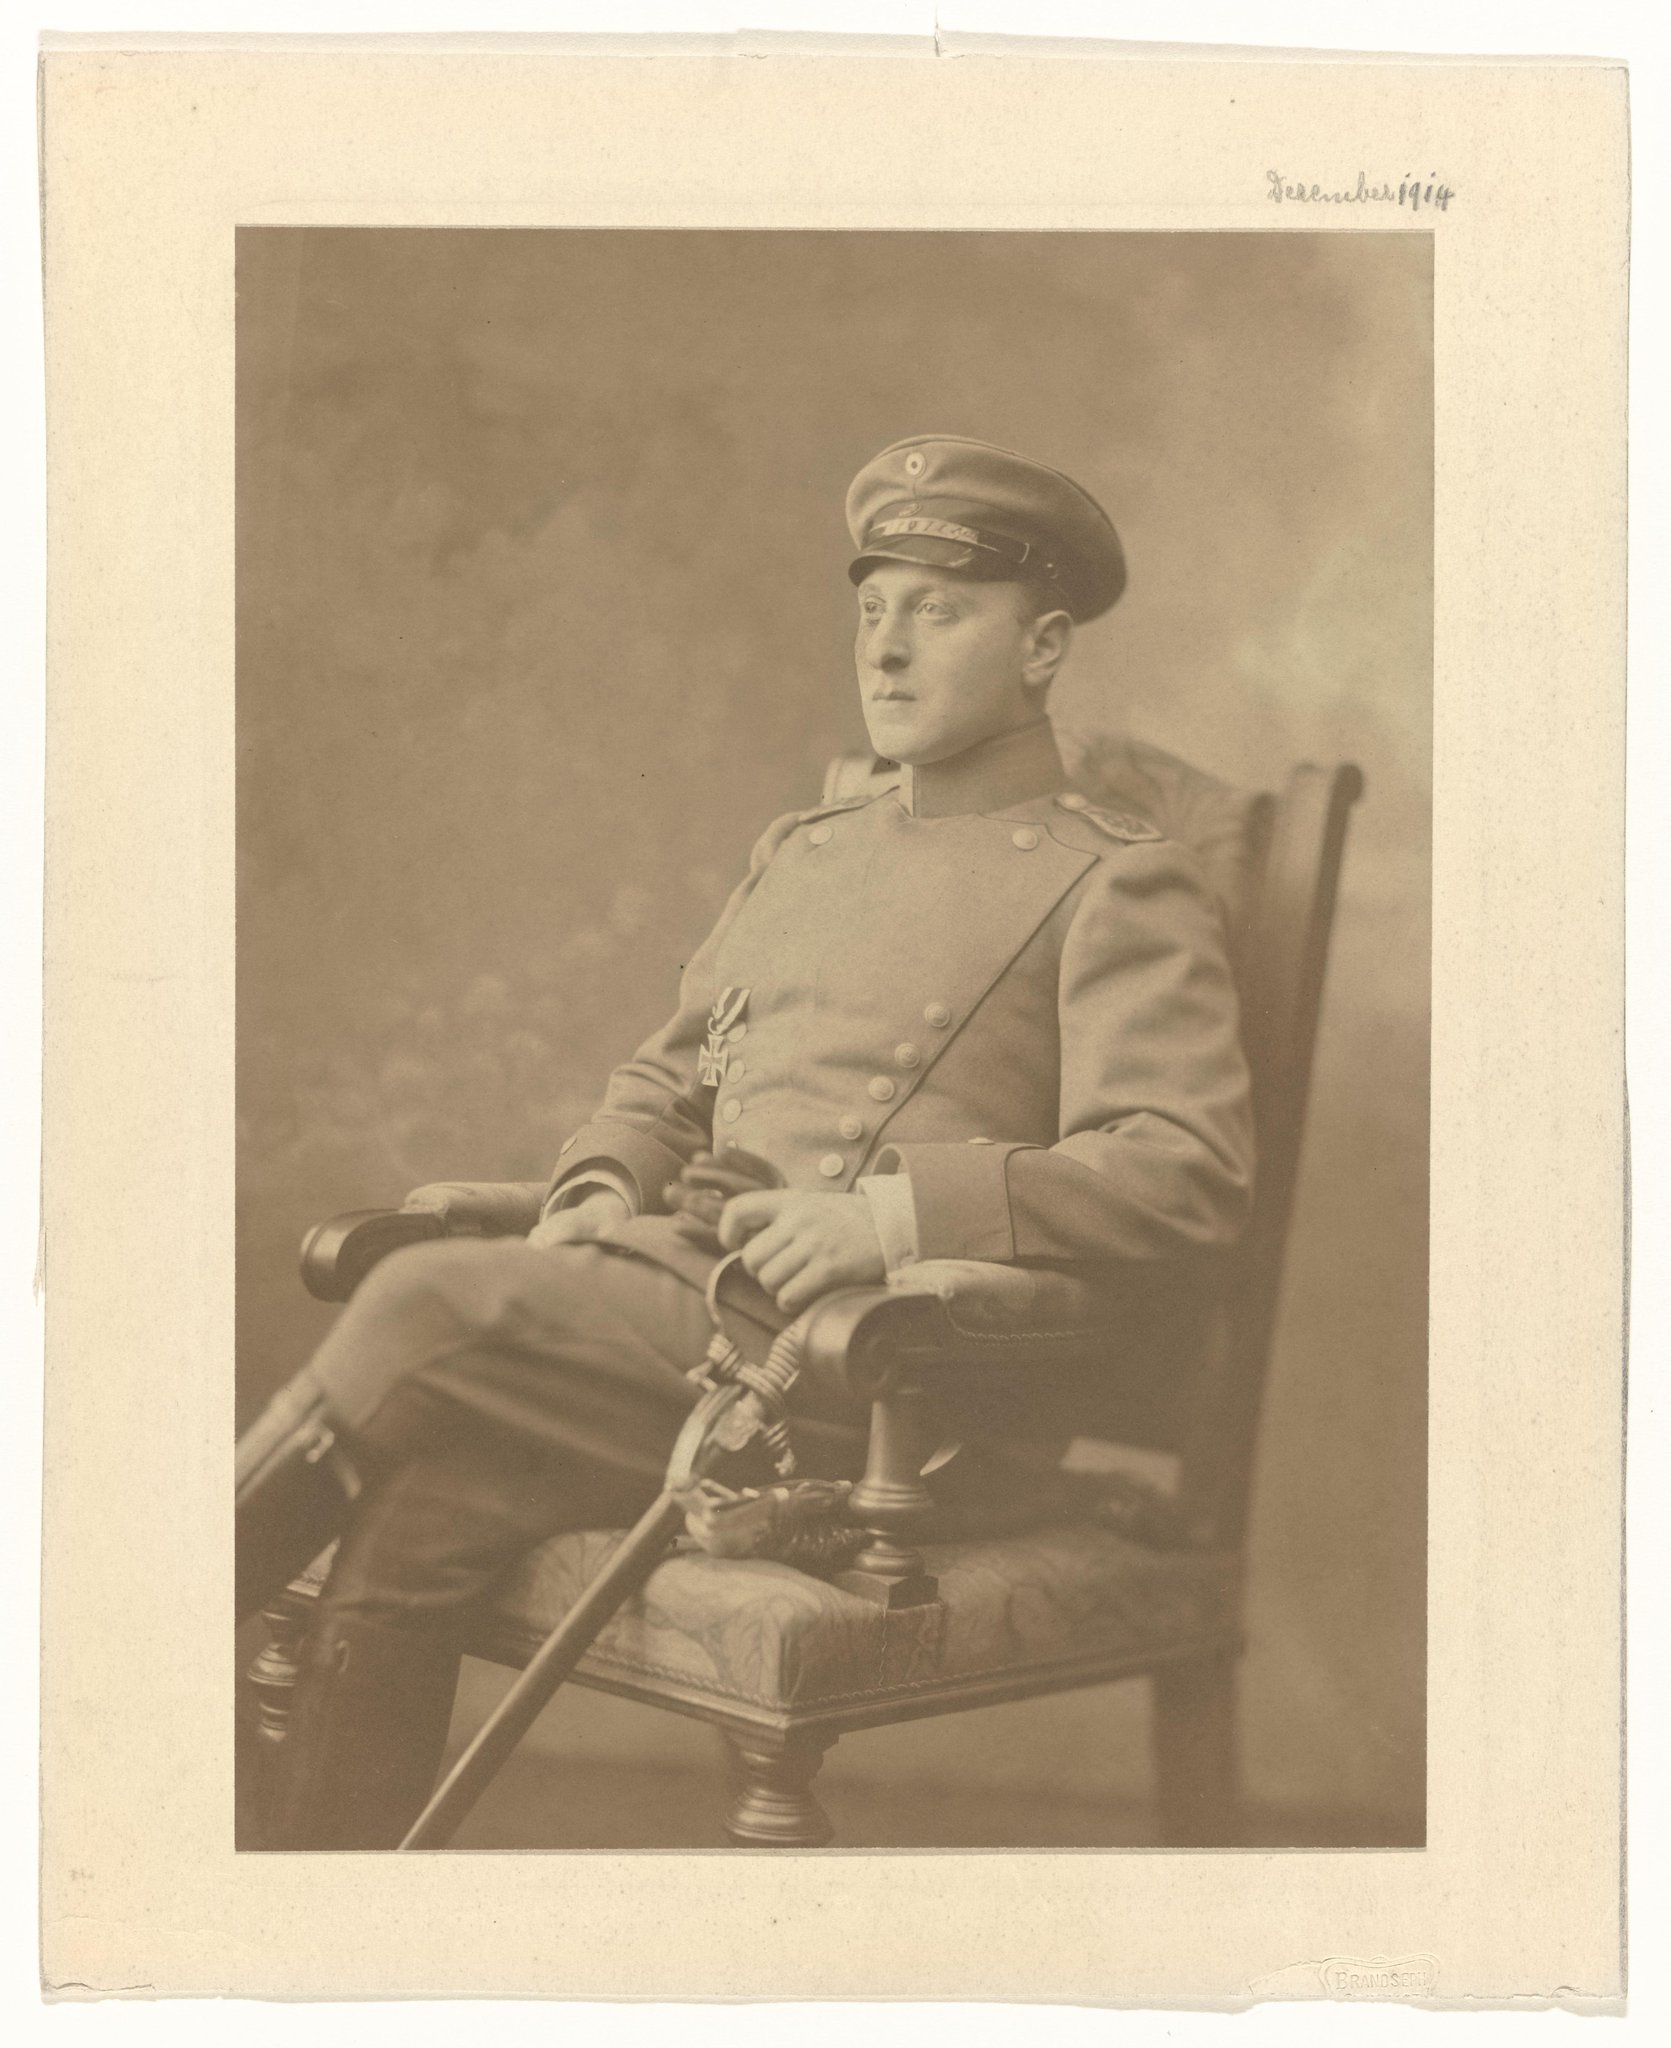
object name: photograph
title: Arthur Moos met sabel in het uniform van het Duitse leger, met het IJzeren Kruis op de borst, gezeten op een stoel, december 1914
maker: Anonymous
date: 1912-1914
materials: photographic support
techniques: gelatin silver print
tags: arthur moos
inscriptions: date: ‘Dezember 1914.’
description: Arthur Moos met sabel in het uniform van het Duitse leger, met het IJzeren Kruis op de borst, gezeten op een stoel.